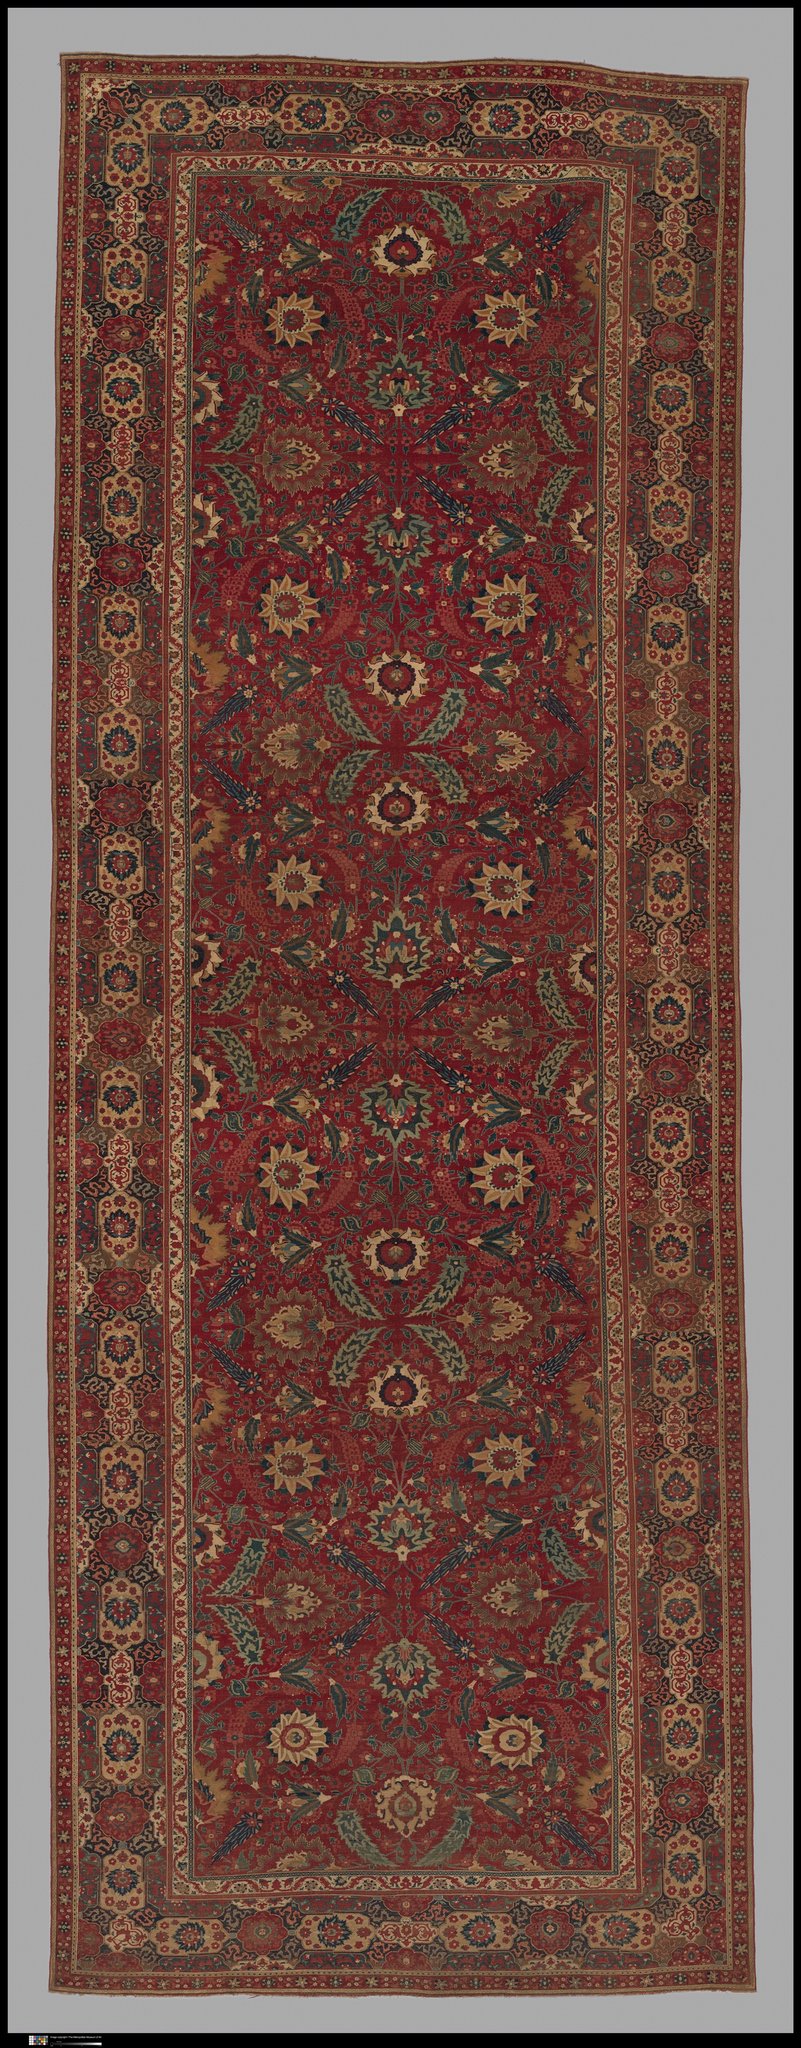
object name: carpet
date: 1634-1666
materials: cotton, wool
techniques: asymmetrically knotted pile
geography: pakistan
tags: flowers